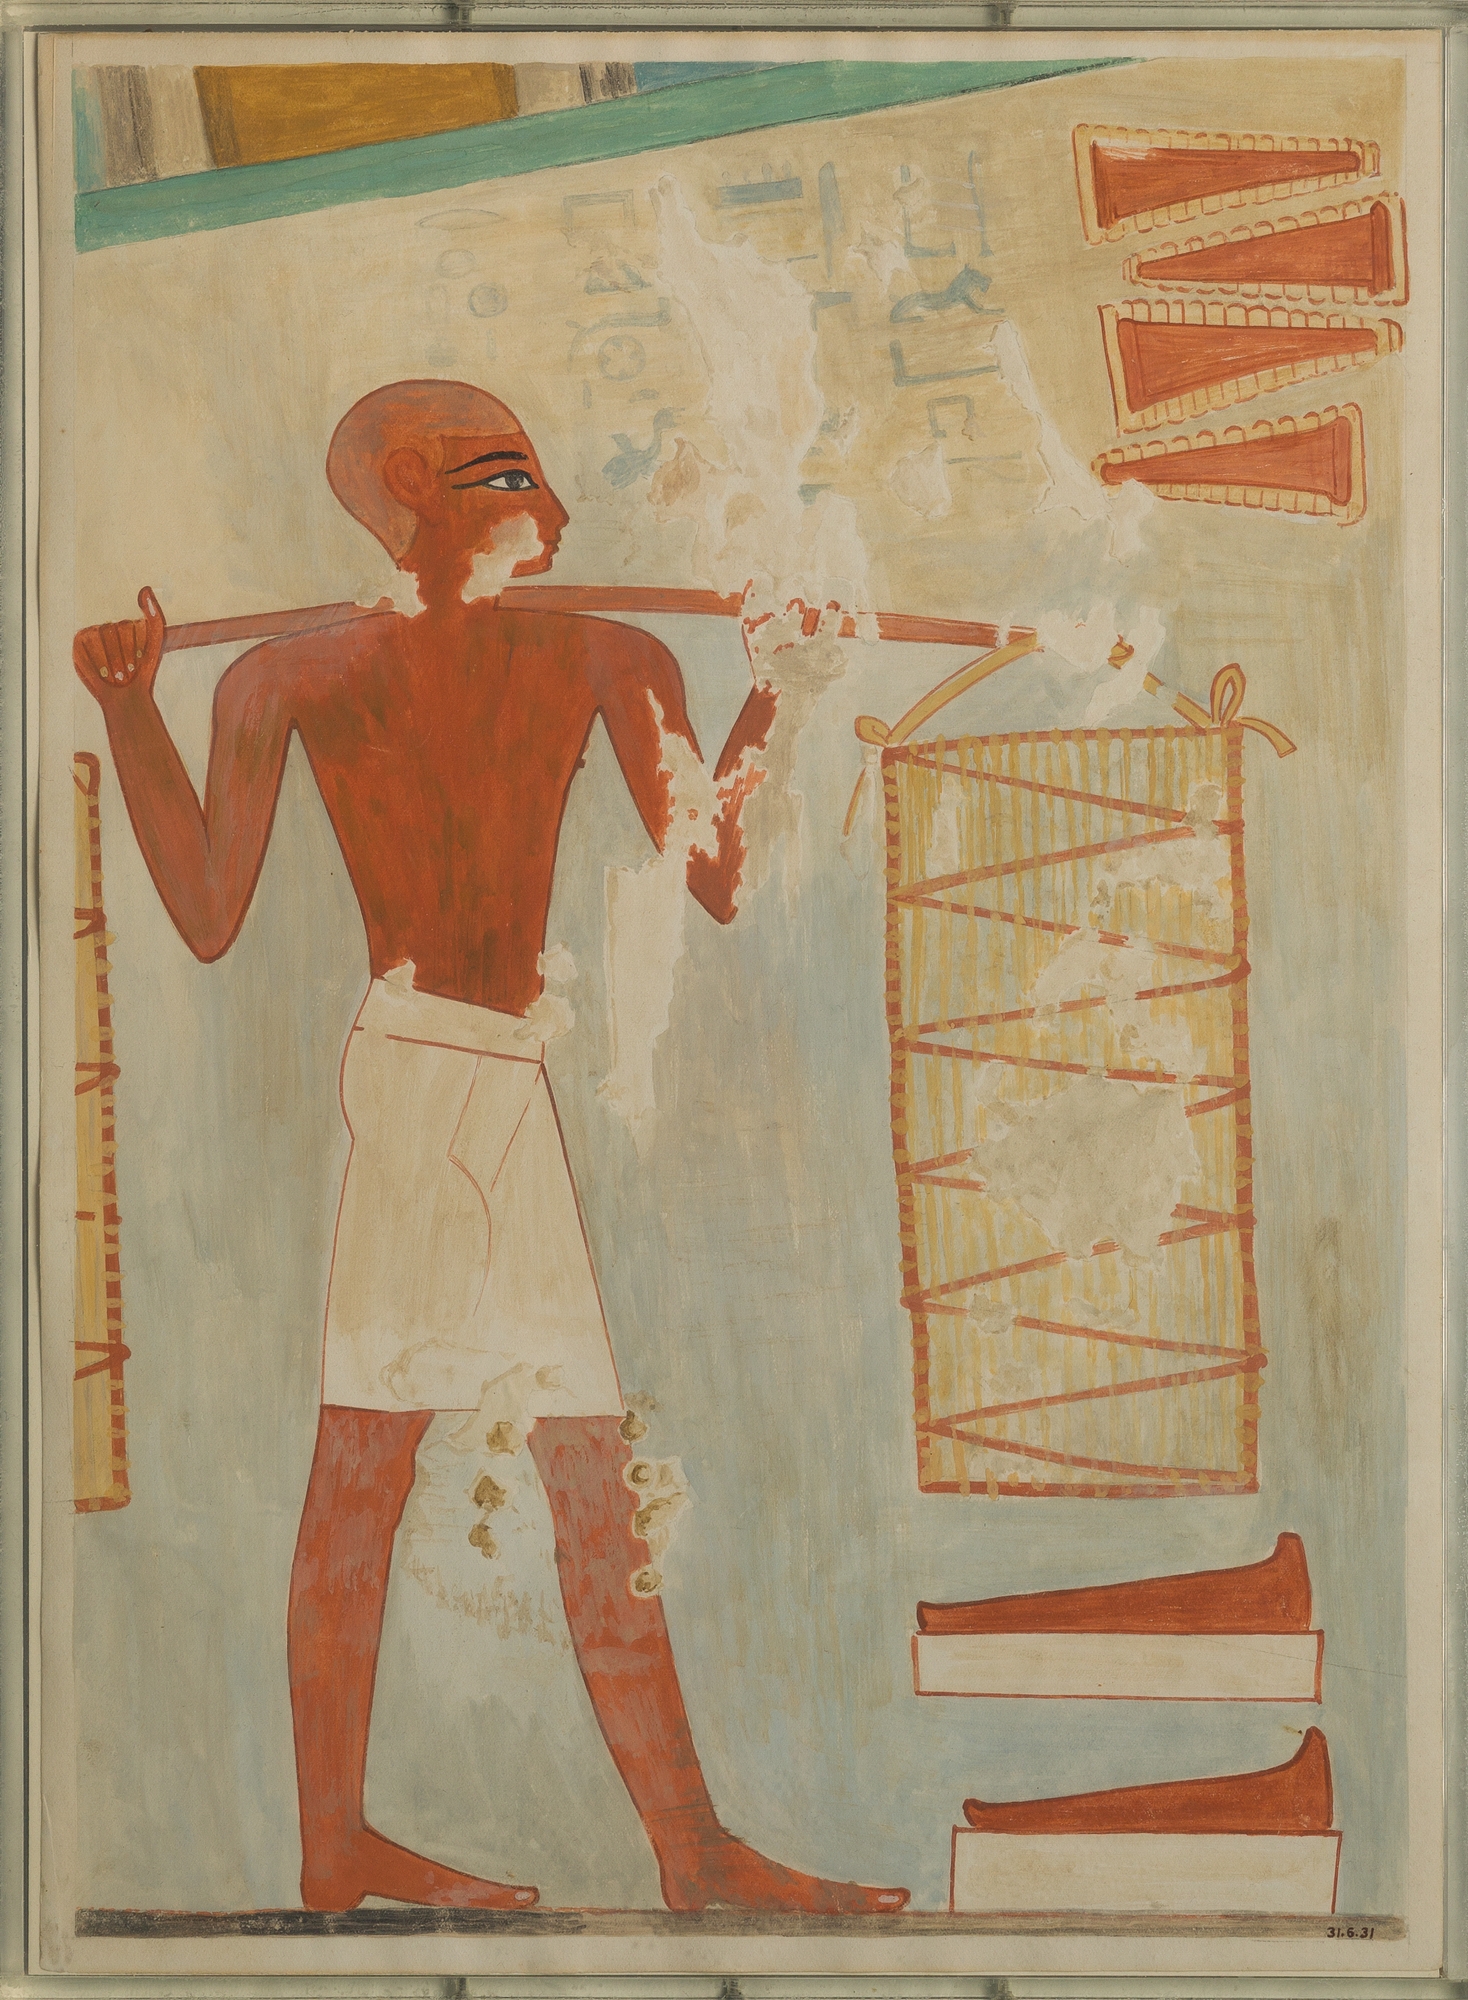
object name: facsimile, rekhmire tt 100, baker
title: Man Carrying Loaves, Tomb of Rekhmire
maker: nina de garis davies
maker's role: artist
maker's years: 1881-1965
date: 1504-1425 BCE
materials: ink, paint, paper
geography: egypt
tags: bread,men,baskets